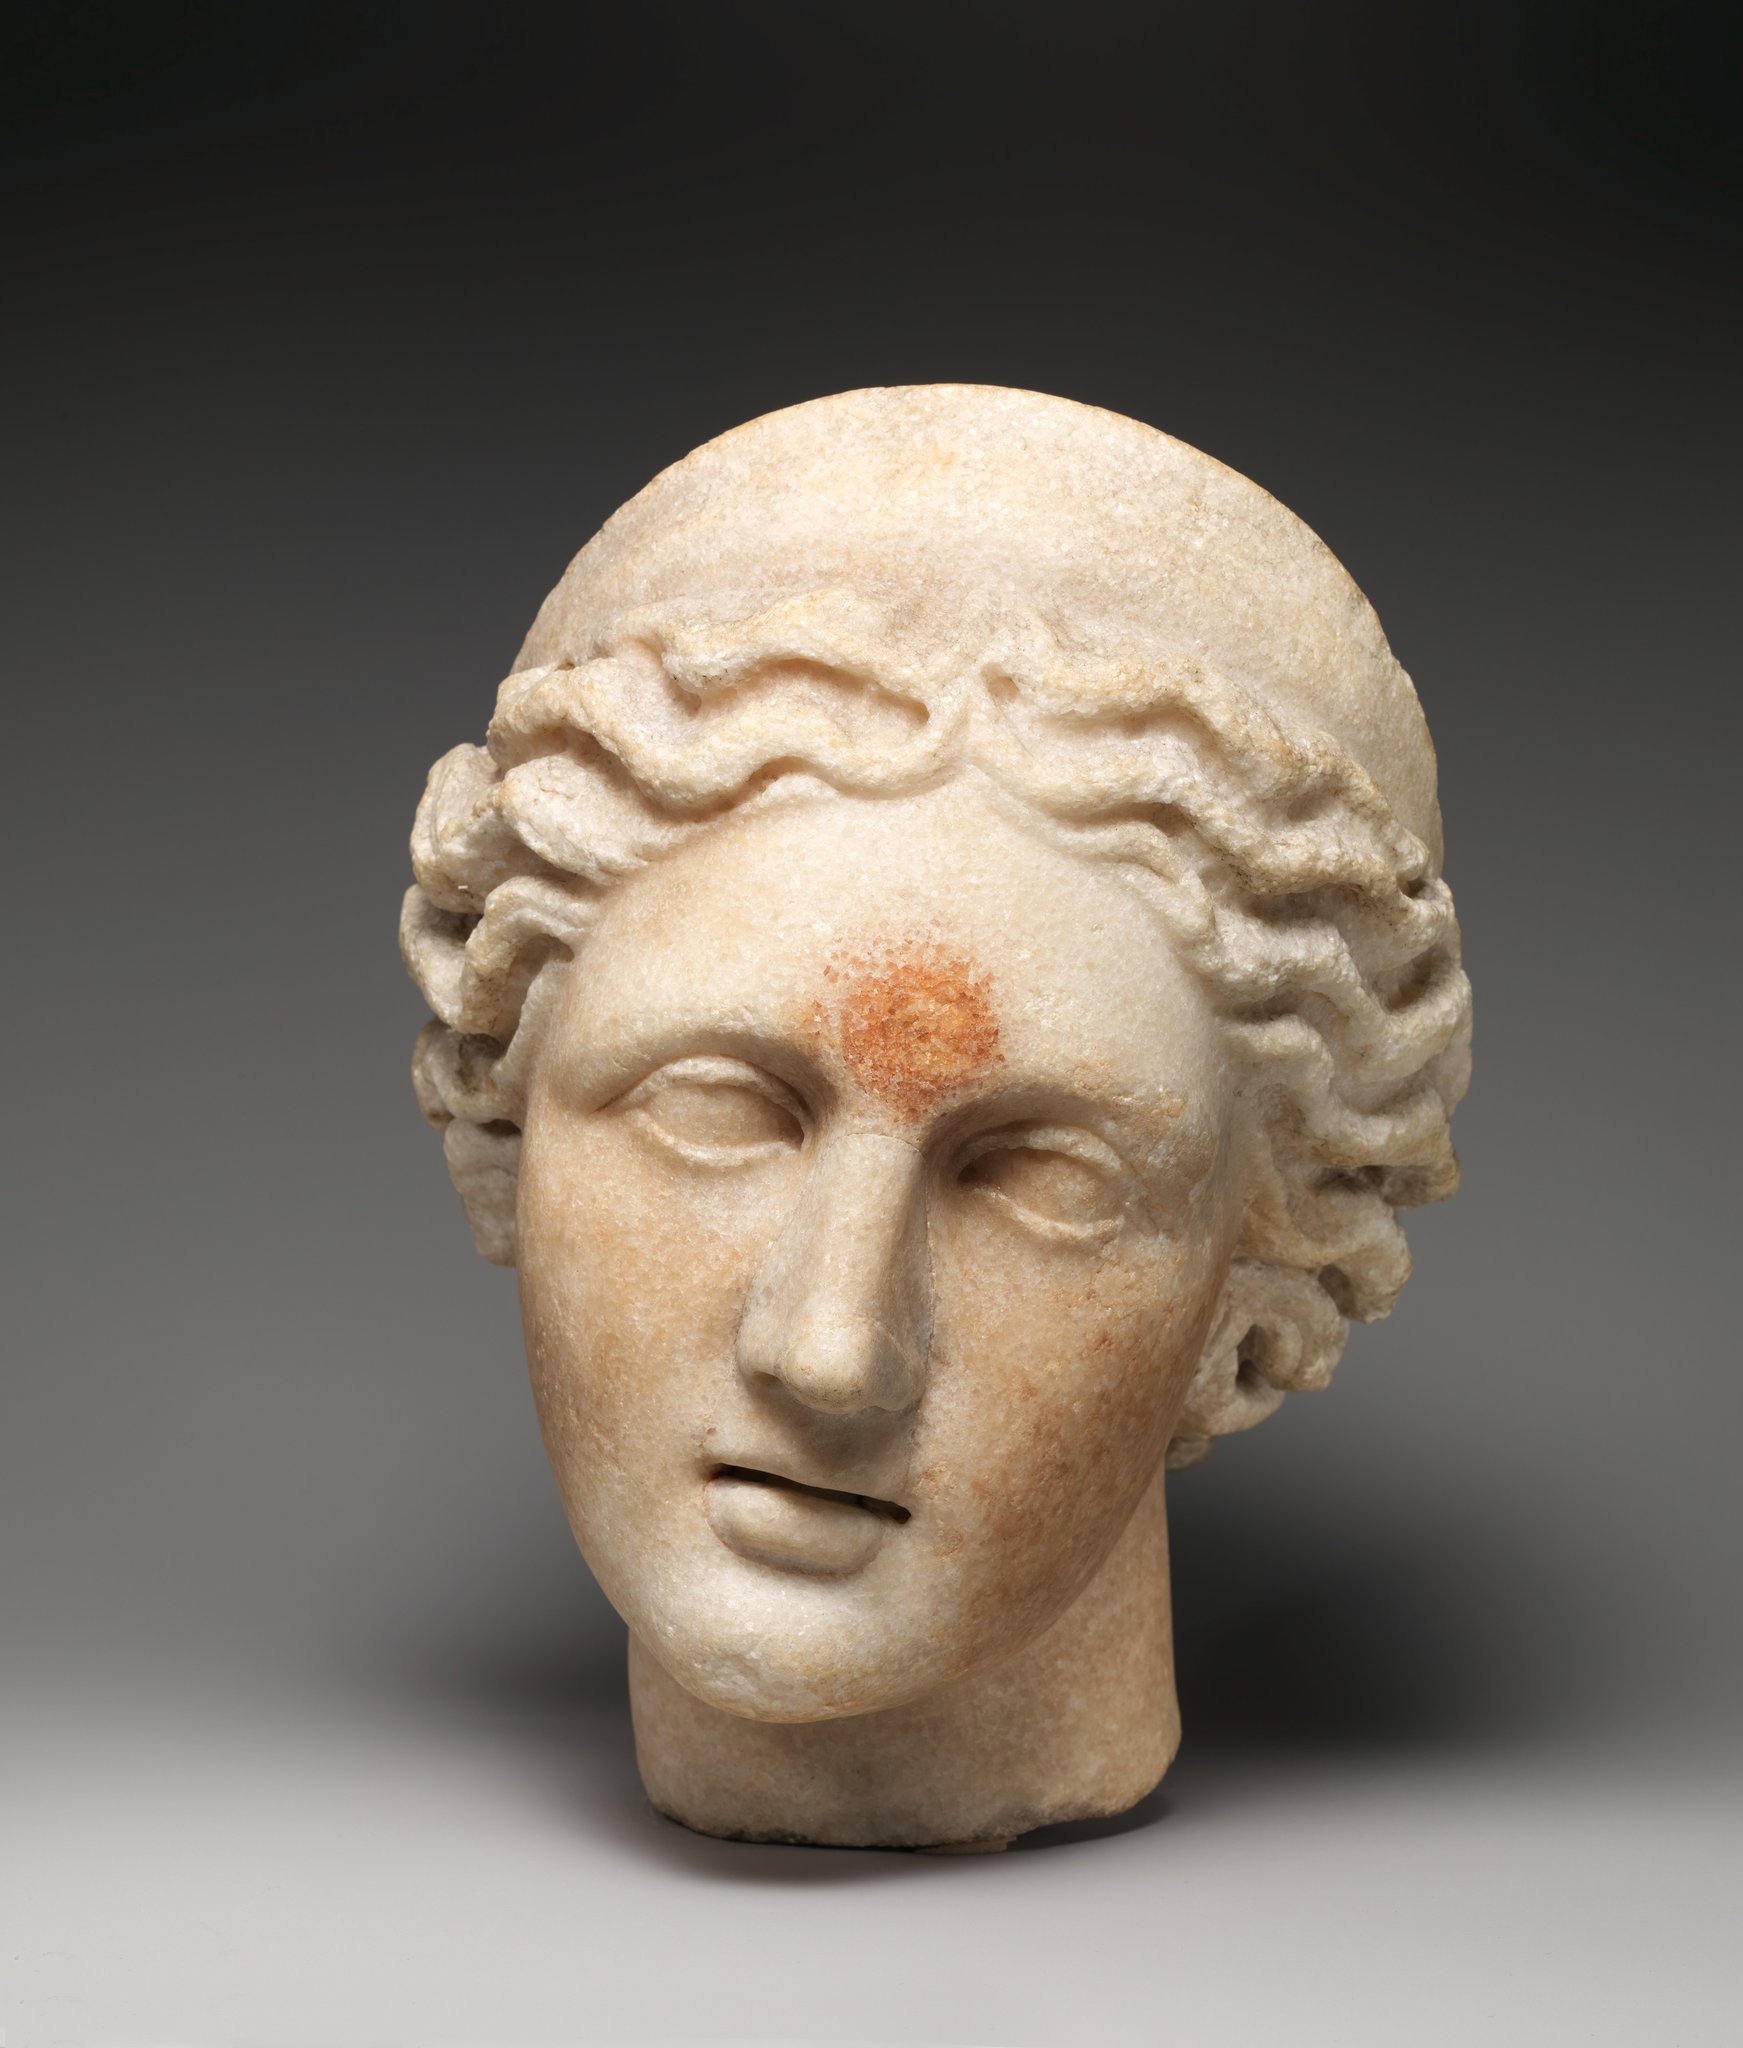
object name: head of a woman wearing diadem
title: Marble head of a goddess wearing a diadem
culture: roman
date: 1-200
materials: marble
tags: diadems,heads,goddess